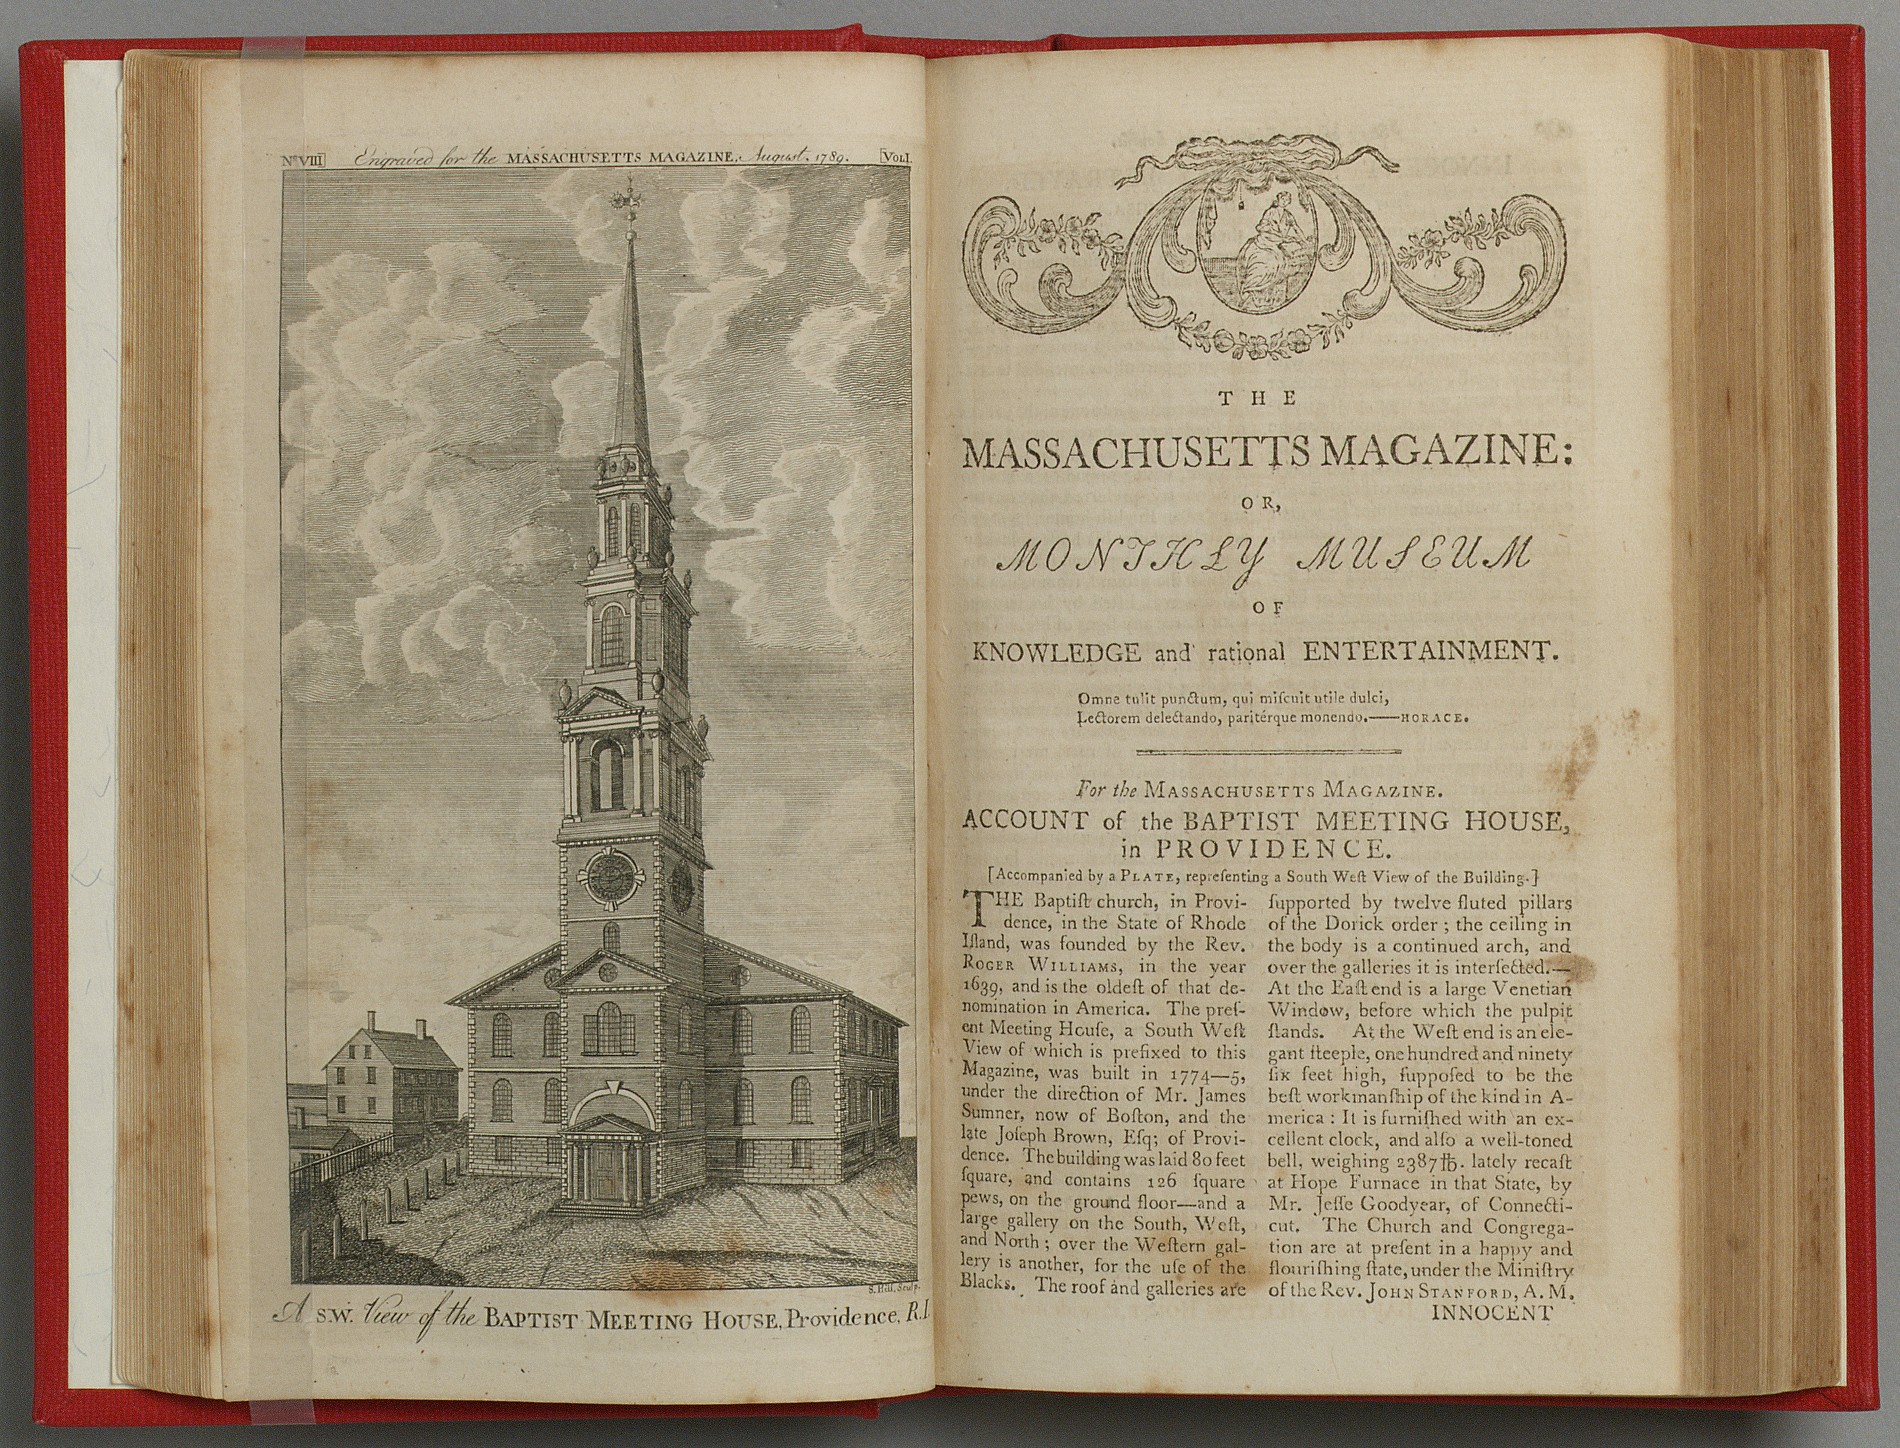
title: The Massachusetts Magazine, or, Monthly Museum of Knowledge and Rational Entertainment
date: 1789-1796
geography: boston: isaiah thomas and ebenezer t. andrews